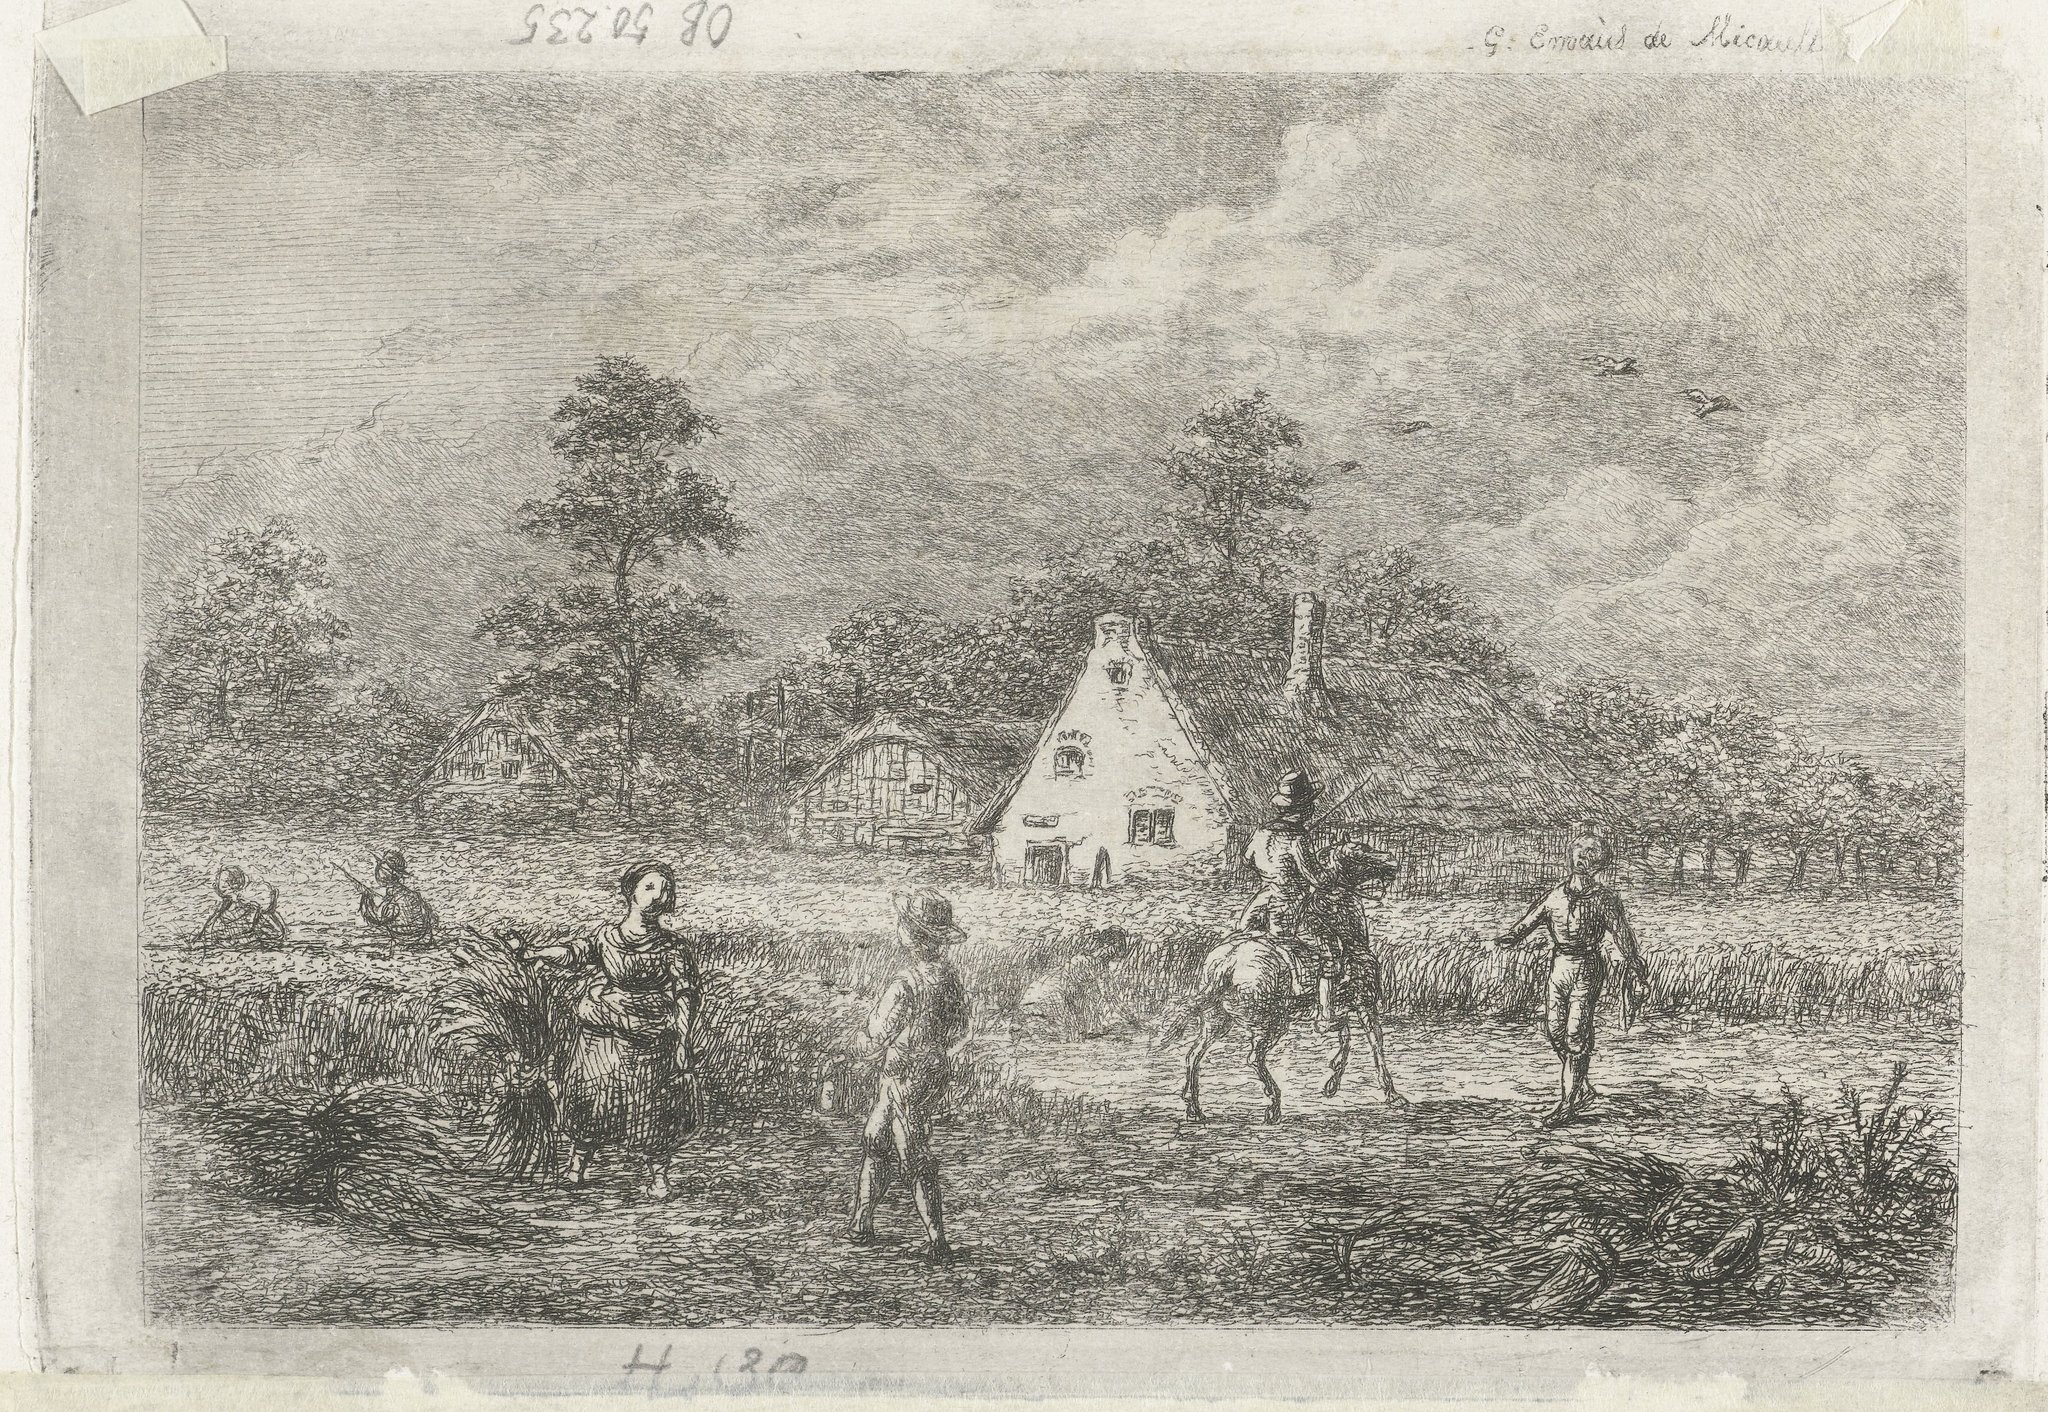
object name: print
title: De oogst bij het dorp Houten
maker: gerardus emaus de micault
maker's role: draughtsman, print maker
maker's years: 1798-1863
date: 1854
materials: paper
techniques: etching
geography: netherlands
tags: harvest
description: Op een veld voor een boerderij zijn vijf personen aan het oogsten. Een ruiter te paard spreekt een zesde persoon aan.